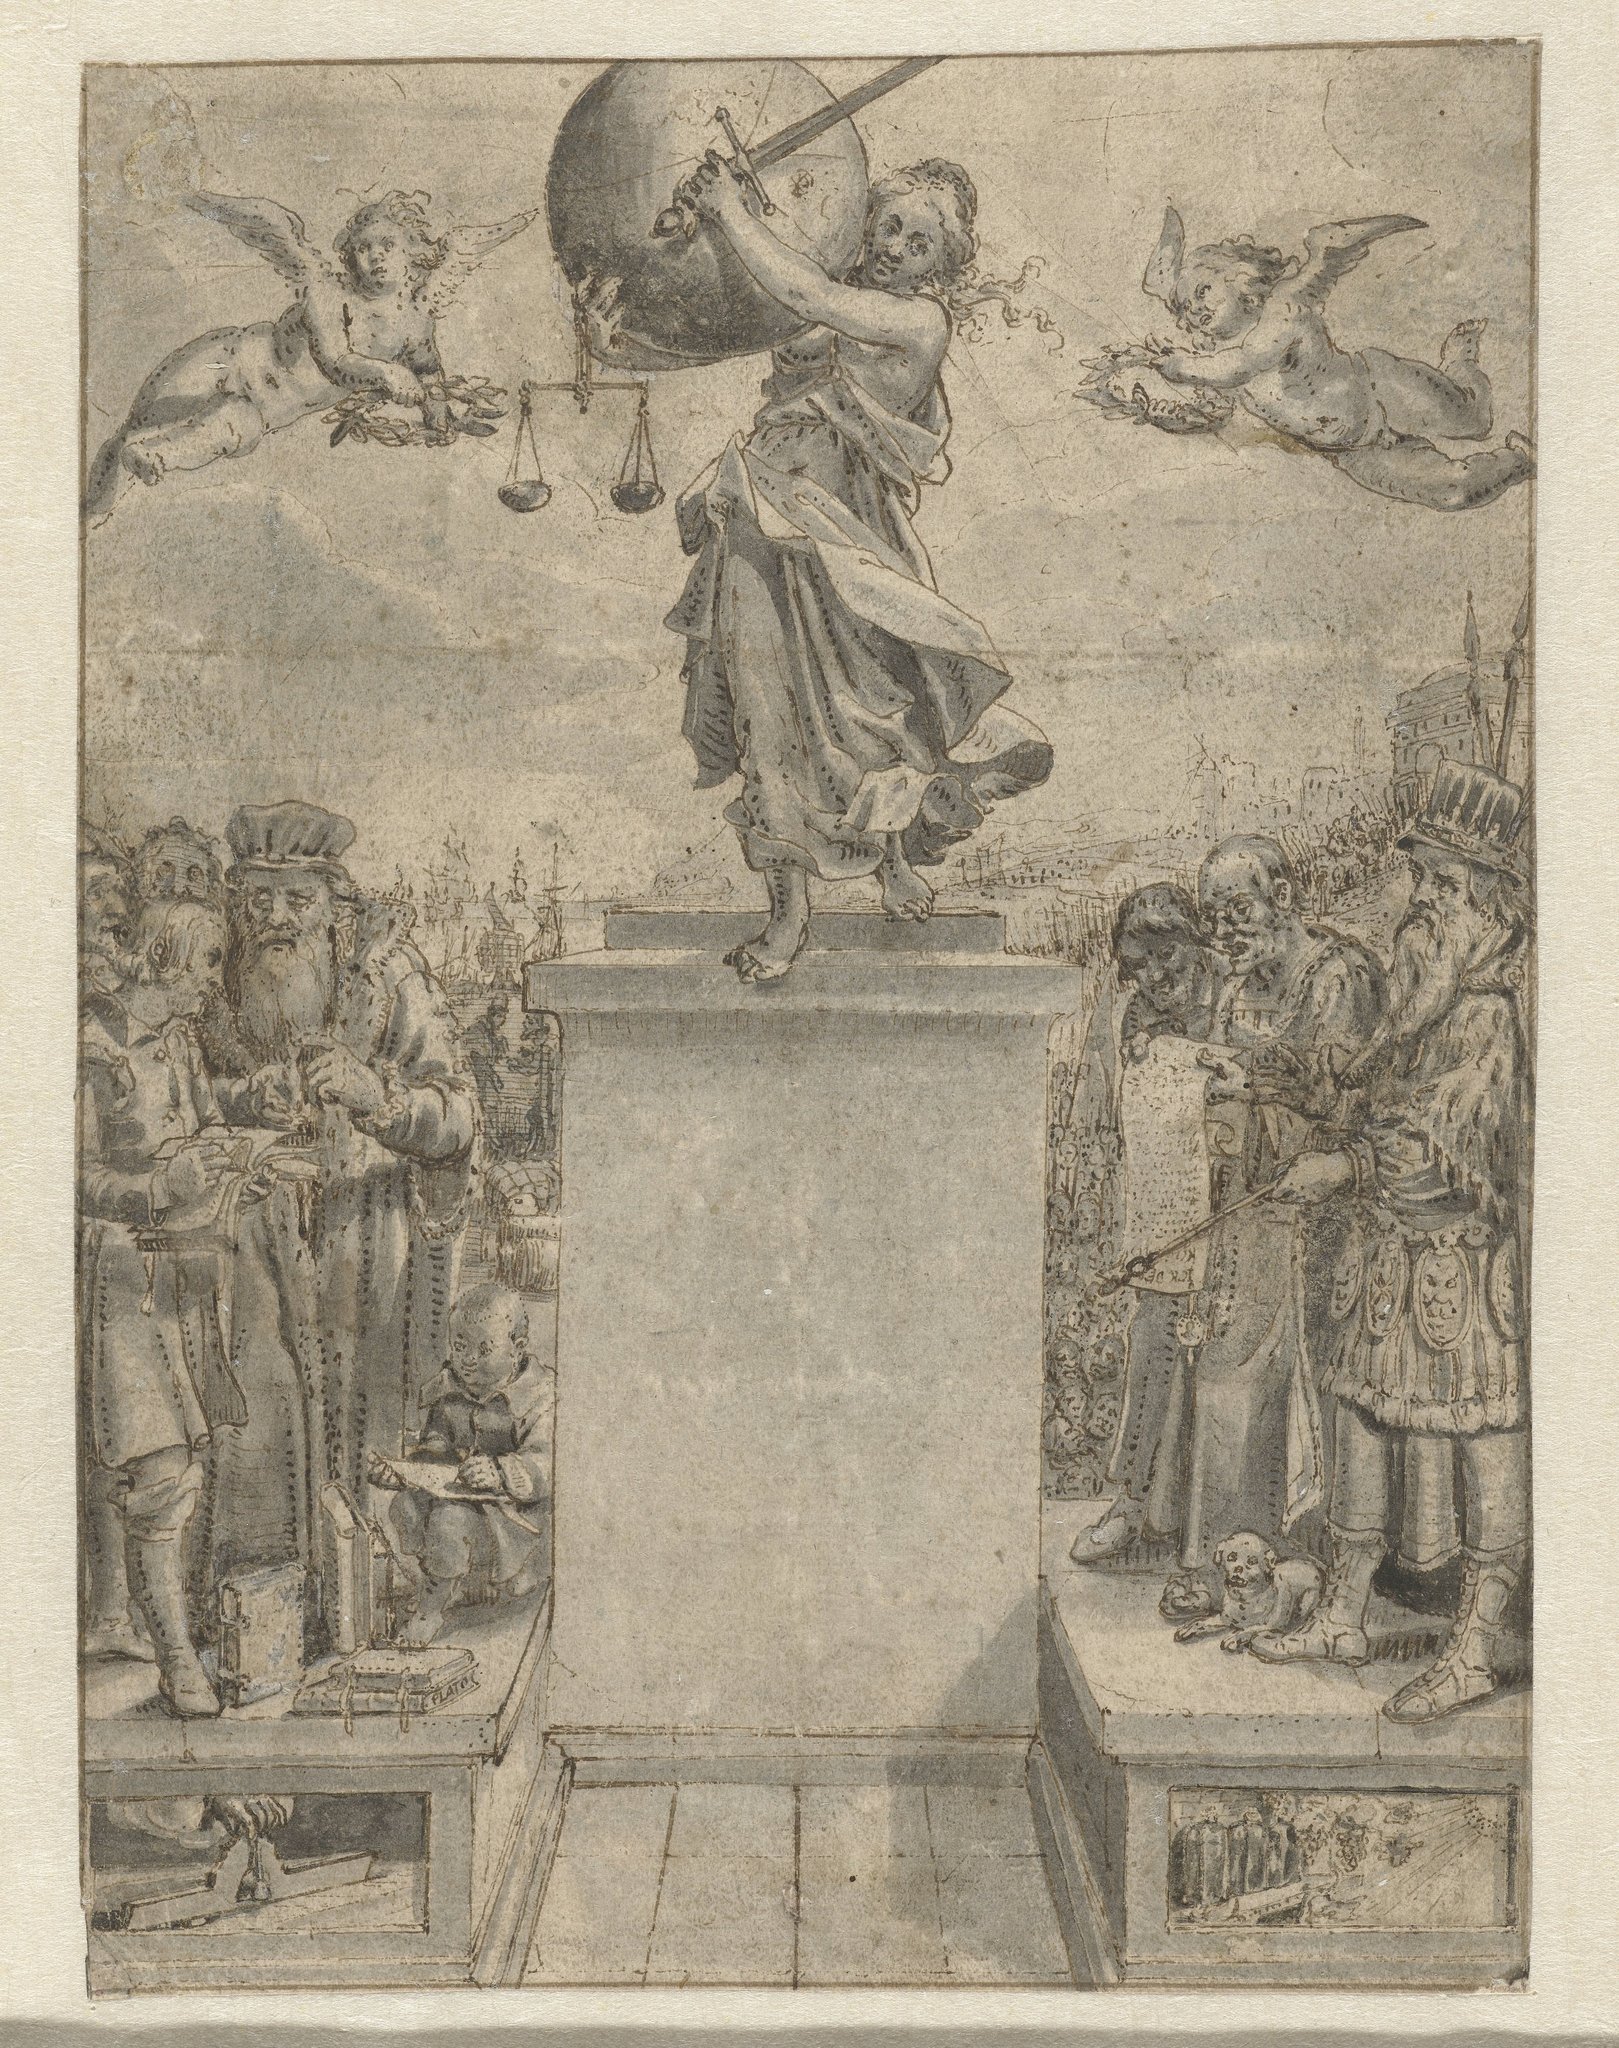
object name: drawing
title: Design of a Title-page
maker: adriaen pietersz van de venne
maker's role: draughtsman, painter, print maker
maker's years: 1589-1662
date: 1618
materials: paint, ink, paper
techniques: brush, pen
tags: justice, 'justitia'; 'giustitia divina' (ripa) ~ one of the four cardinal virtues, justice; 'forza alla giustitia sottoposta', 'giustitia', 'giustitia retta', 'giustitia rigorosa', 'impietà e violenza soggetta alla giustitia' (ripa) (+ abstract concept represented by female figure)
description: Ontwerp voor het titelblad van Jacob Cats' 'SinneBeelden, eertijts Minne-beelden, nu gebruyckt ter Leere der Seden' van 1618.